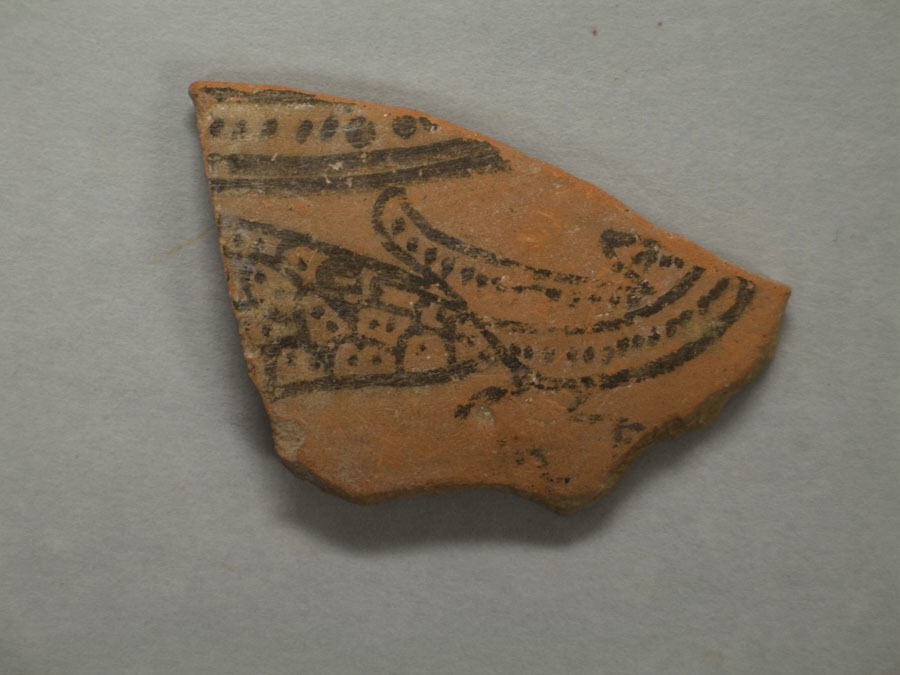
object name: shard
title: Shard: Bird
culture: pakistani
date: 301-500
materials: terracotta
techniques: painting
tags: birds,gandhara